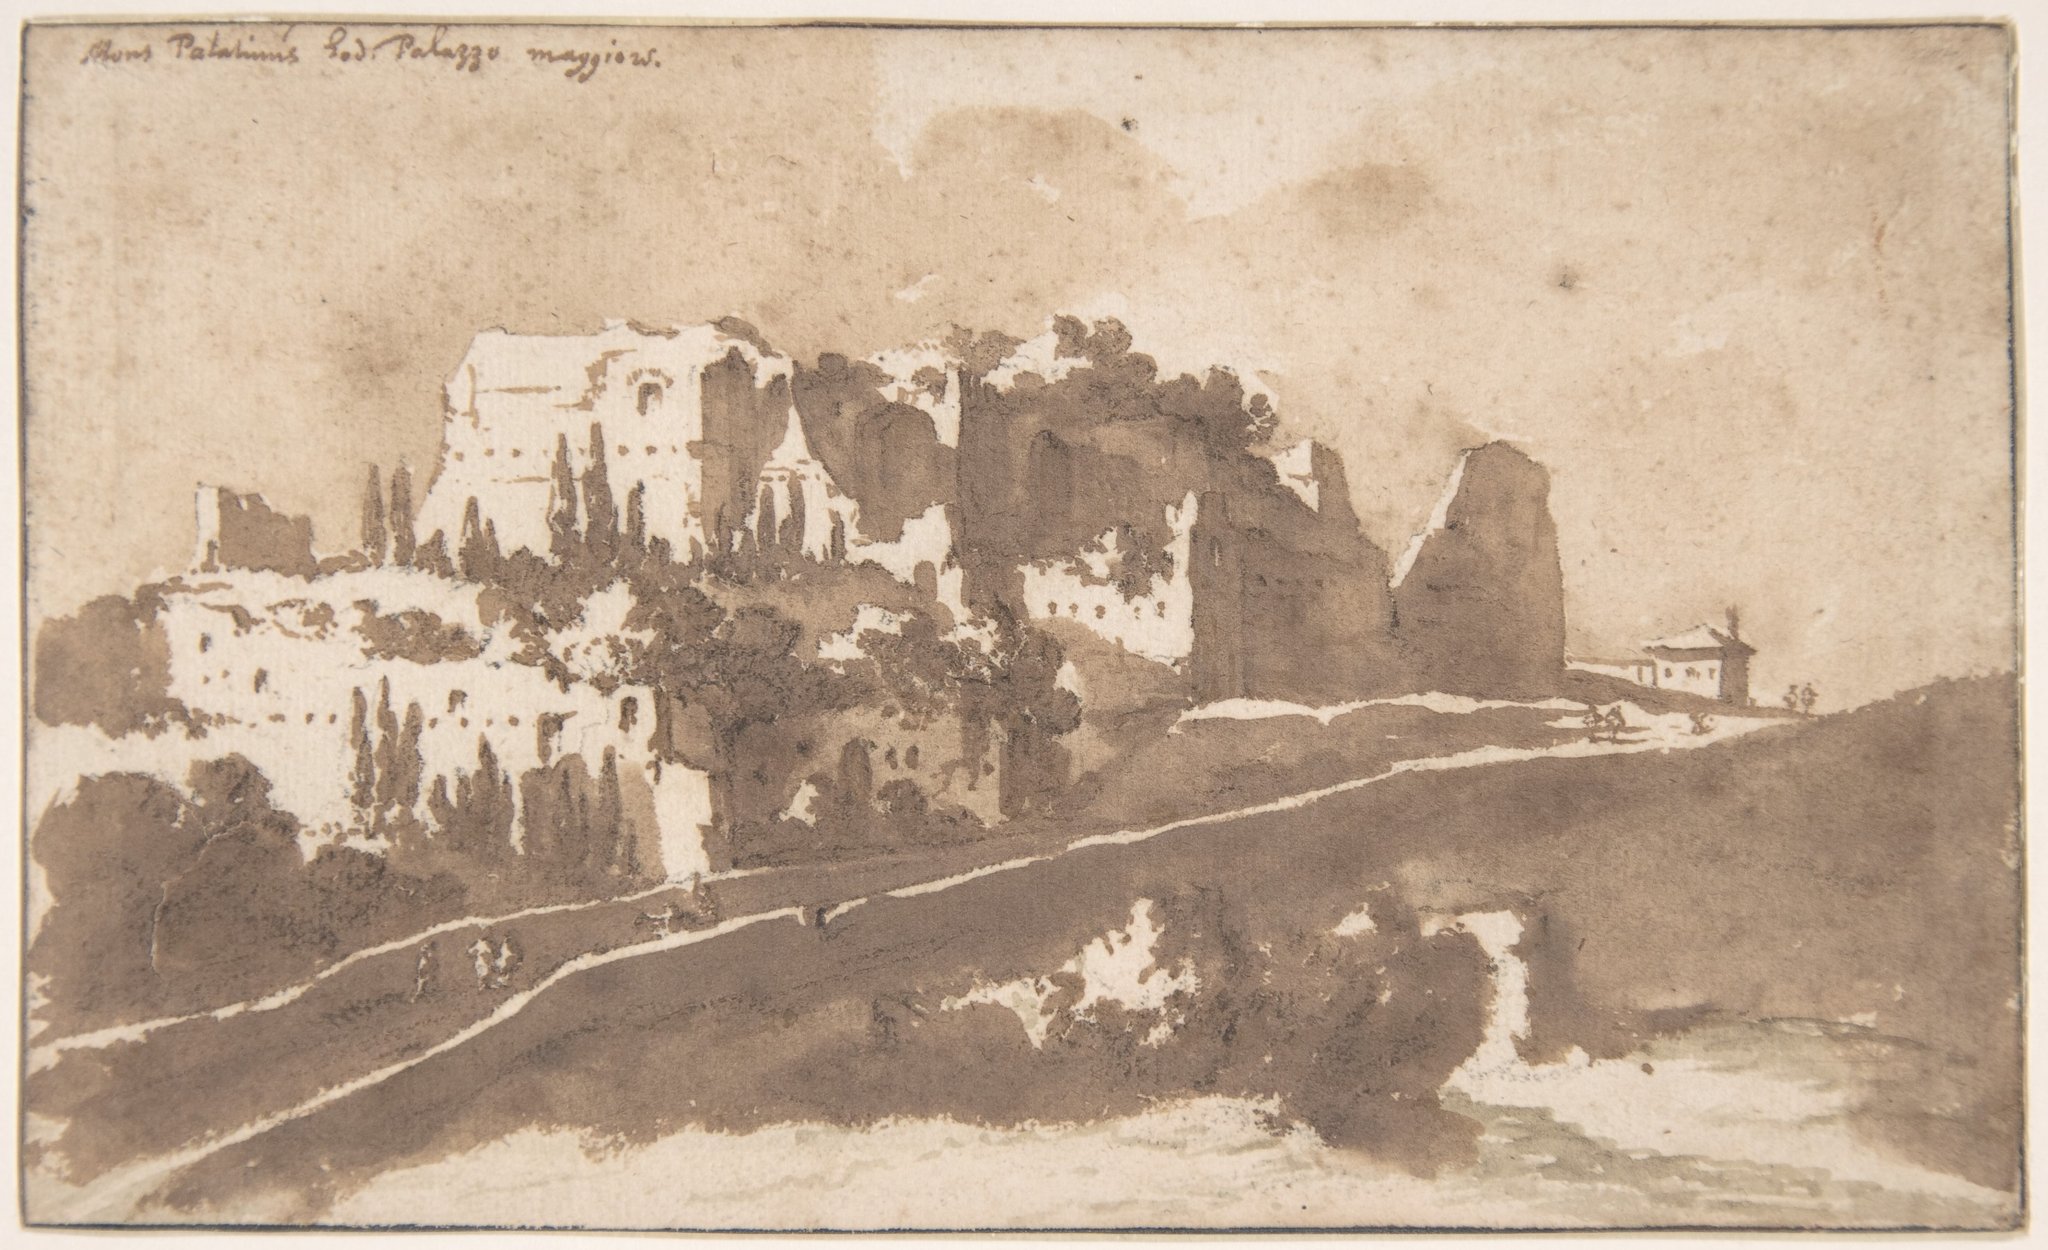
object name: drawing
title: View of the "Palazzo Maggiore" on the Palatine Hill, Rome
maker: jan de bisschop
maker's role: artist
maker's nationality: dutch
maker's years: 1628-1671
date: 1634-1666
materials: chalk, ink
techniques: brush, pen, wash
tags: streets,ruins